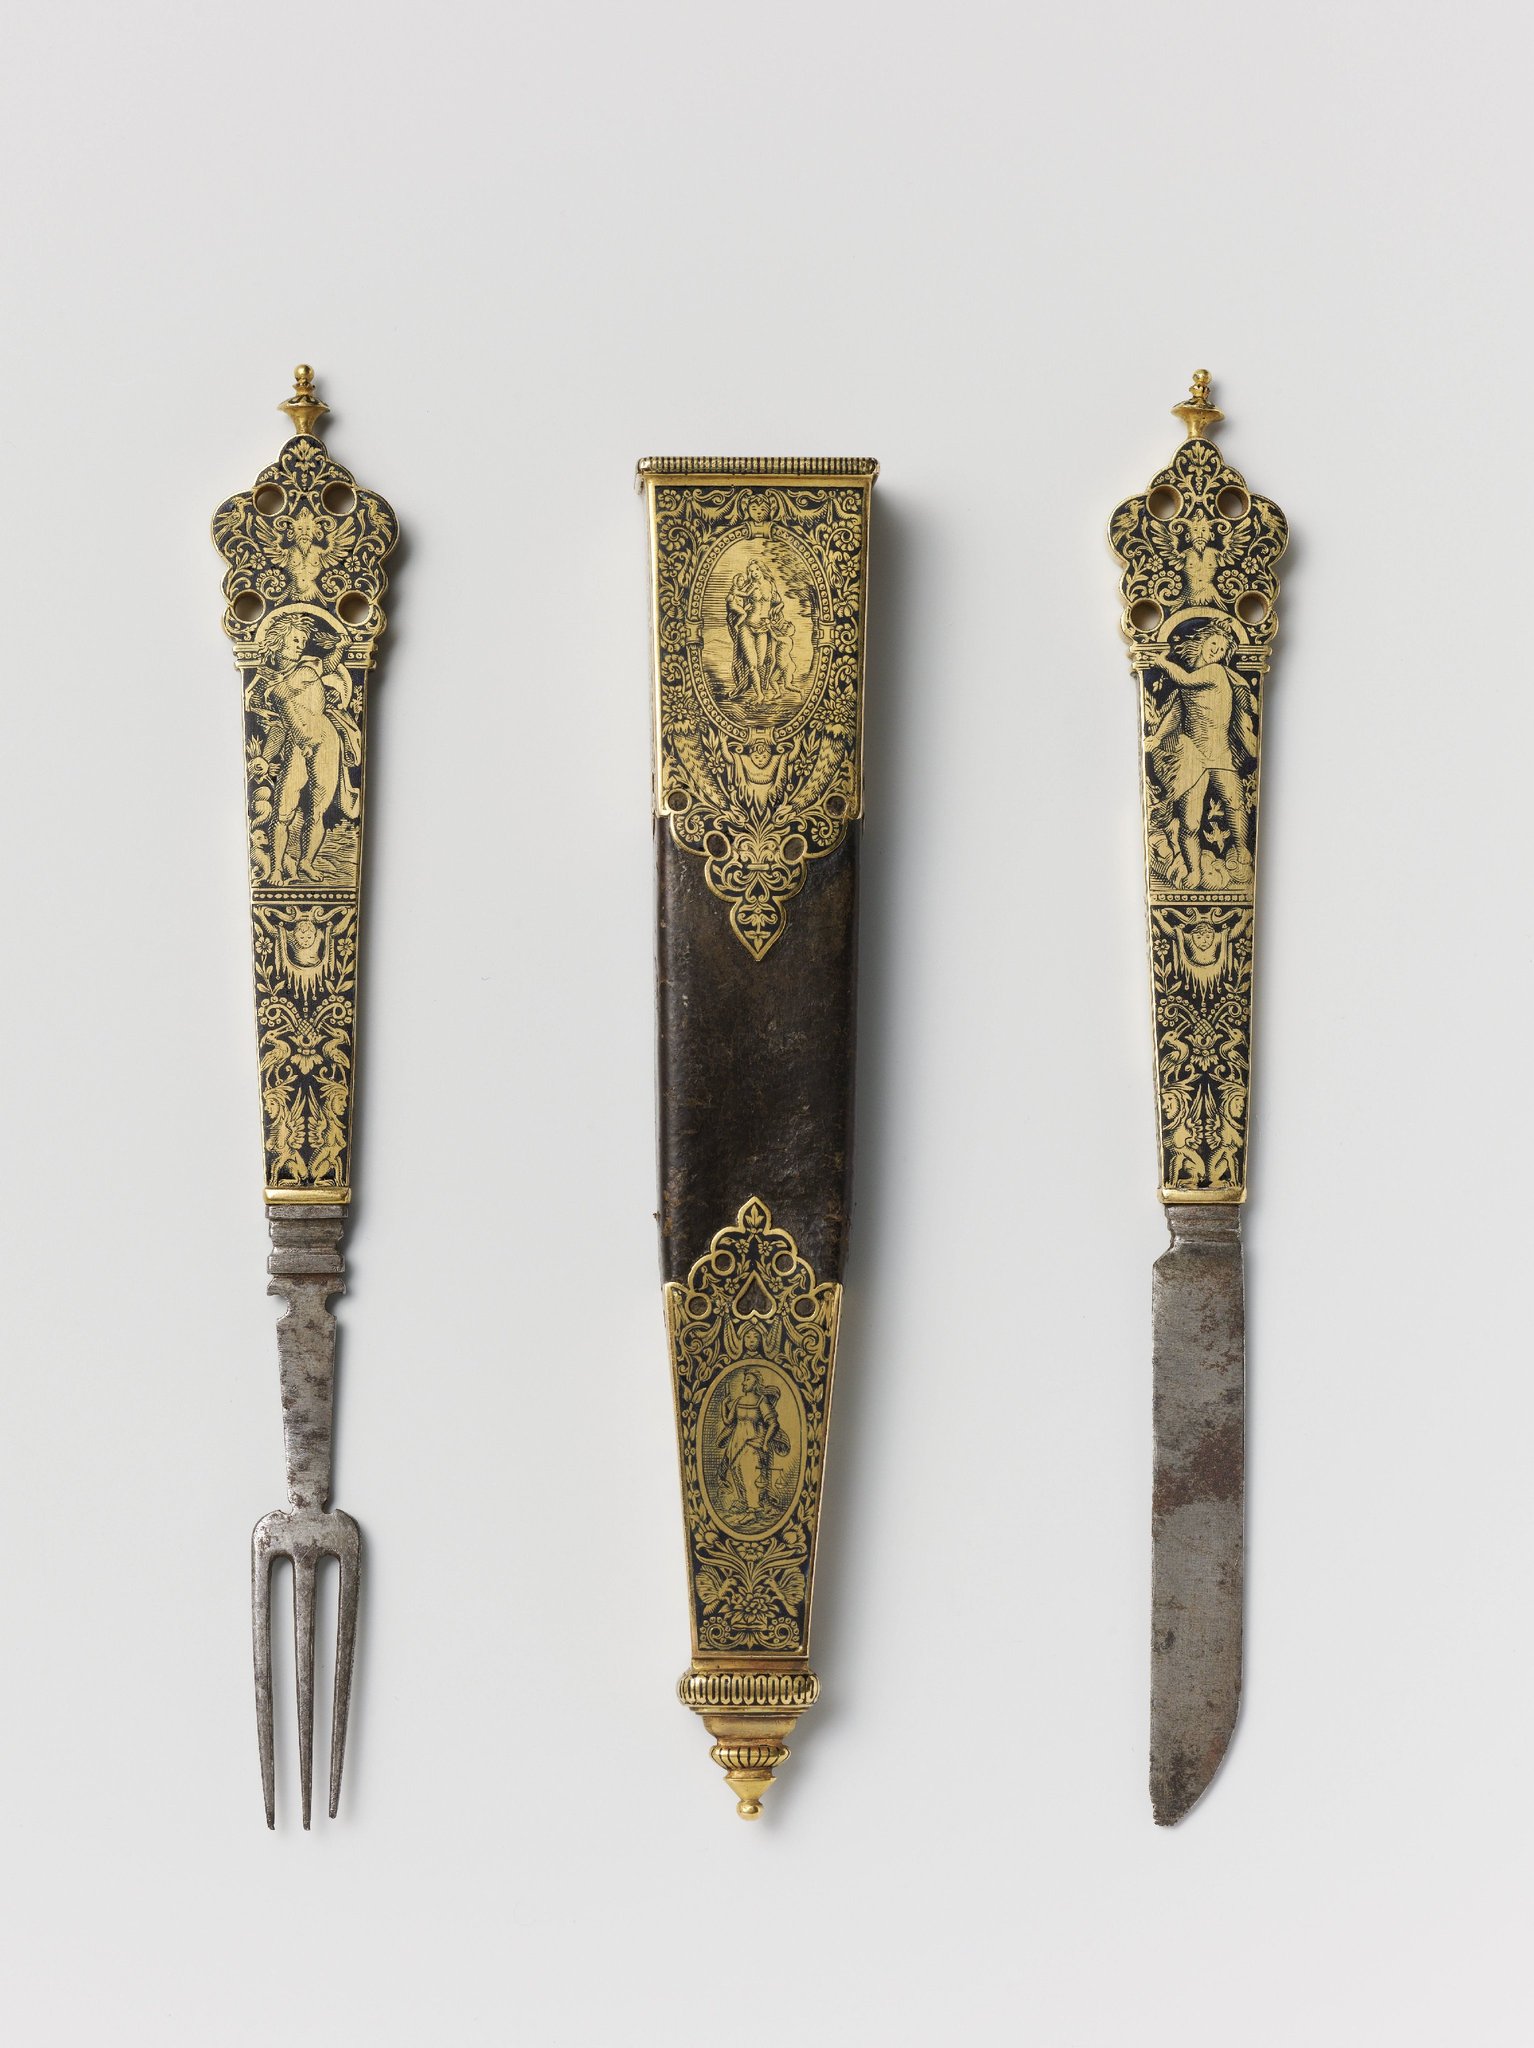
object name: bruidsbestek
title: Wedding knife and fork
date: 1597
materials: gold, iron, leather, niello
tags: charity, 'caritas'; 'carità' (ripa) ~ one of the three theological virtues, justice, 'justitia'; 'giustitia divina' (ripa) ~ one of the four cardinal virtues, ornaments ~ art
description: In the 16th century a groom would give his bride a set of wedding cutlery bearing their names or initials. This gold set is distinguished by its refined engraving, the designs of which were inspired by contemporary prints by Theodor de Bry. In the cutlery, the dark passages of the prints are executed in niello (a black mixture of silver, lead and sulphur).